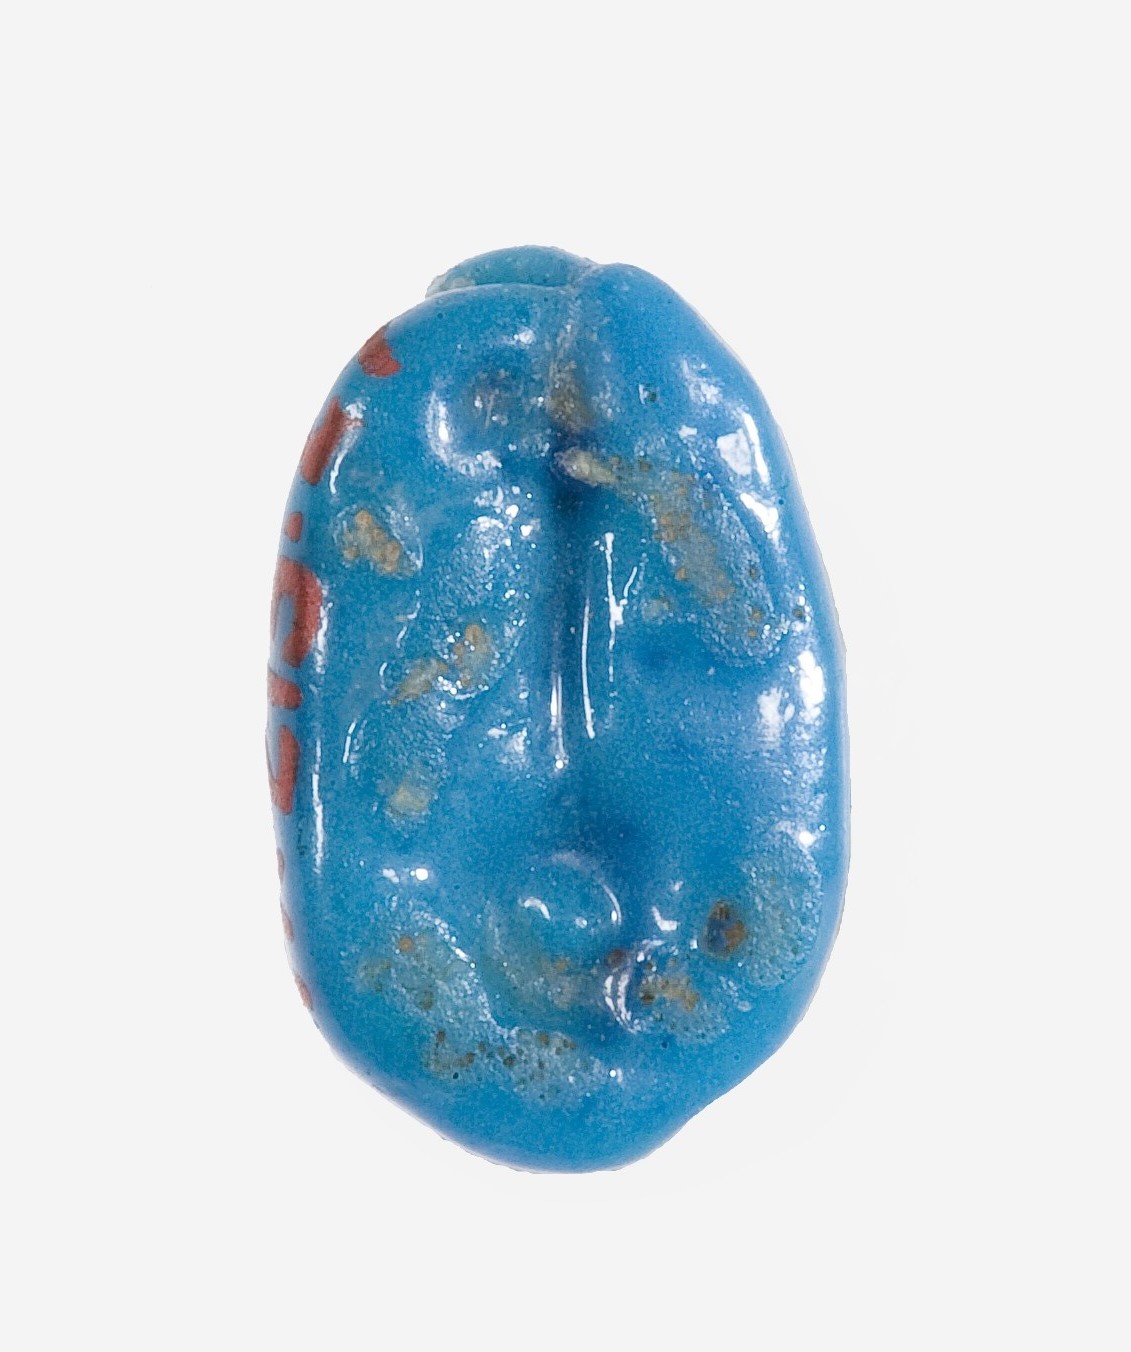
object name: scarab, nefer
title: Scarab With a Nefer Hieroglyph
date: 1390-1352 BCE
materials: faience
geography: egypt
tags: hieroglyphs,scarabs